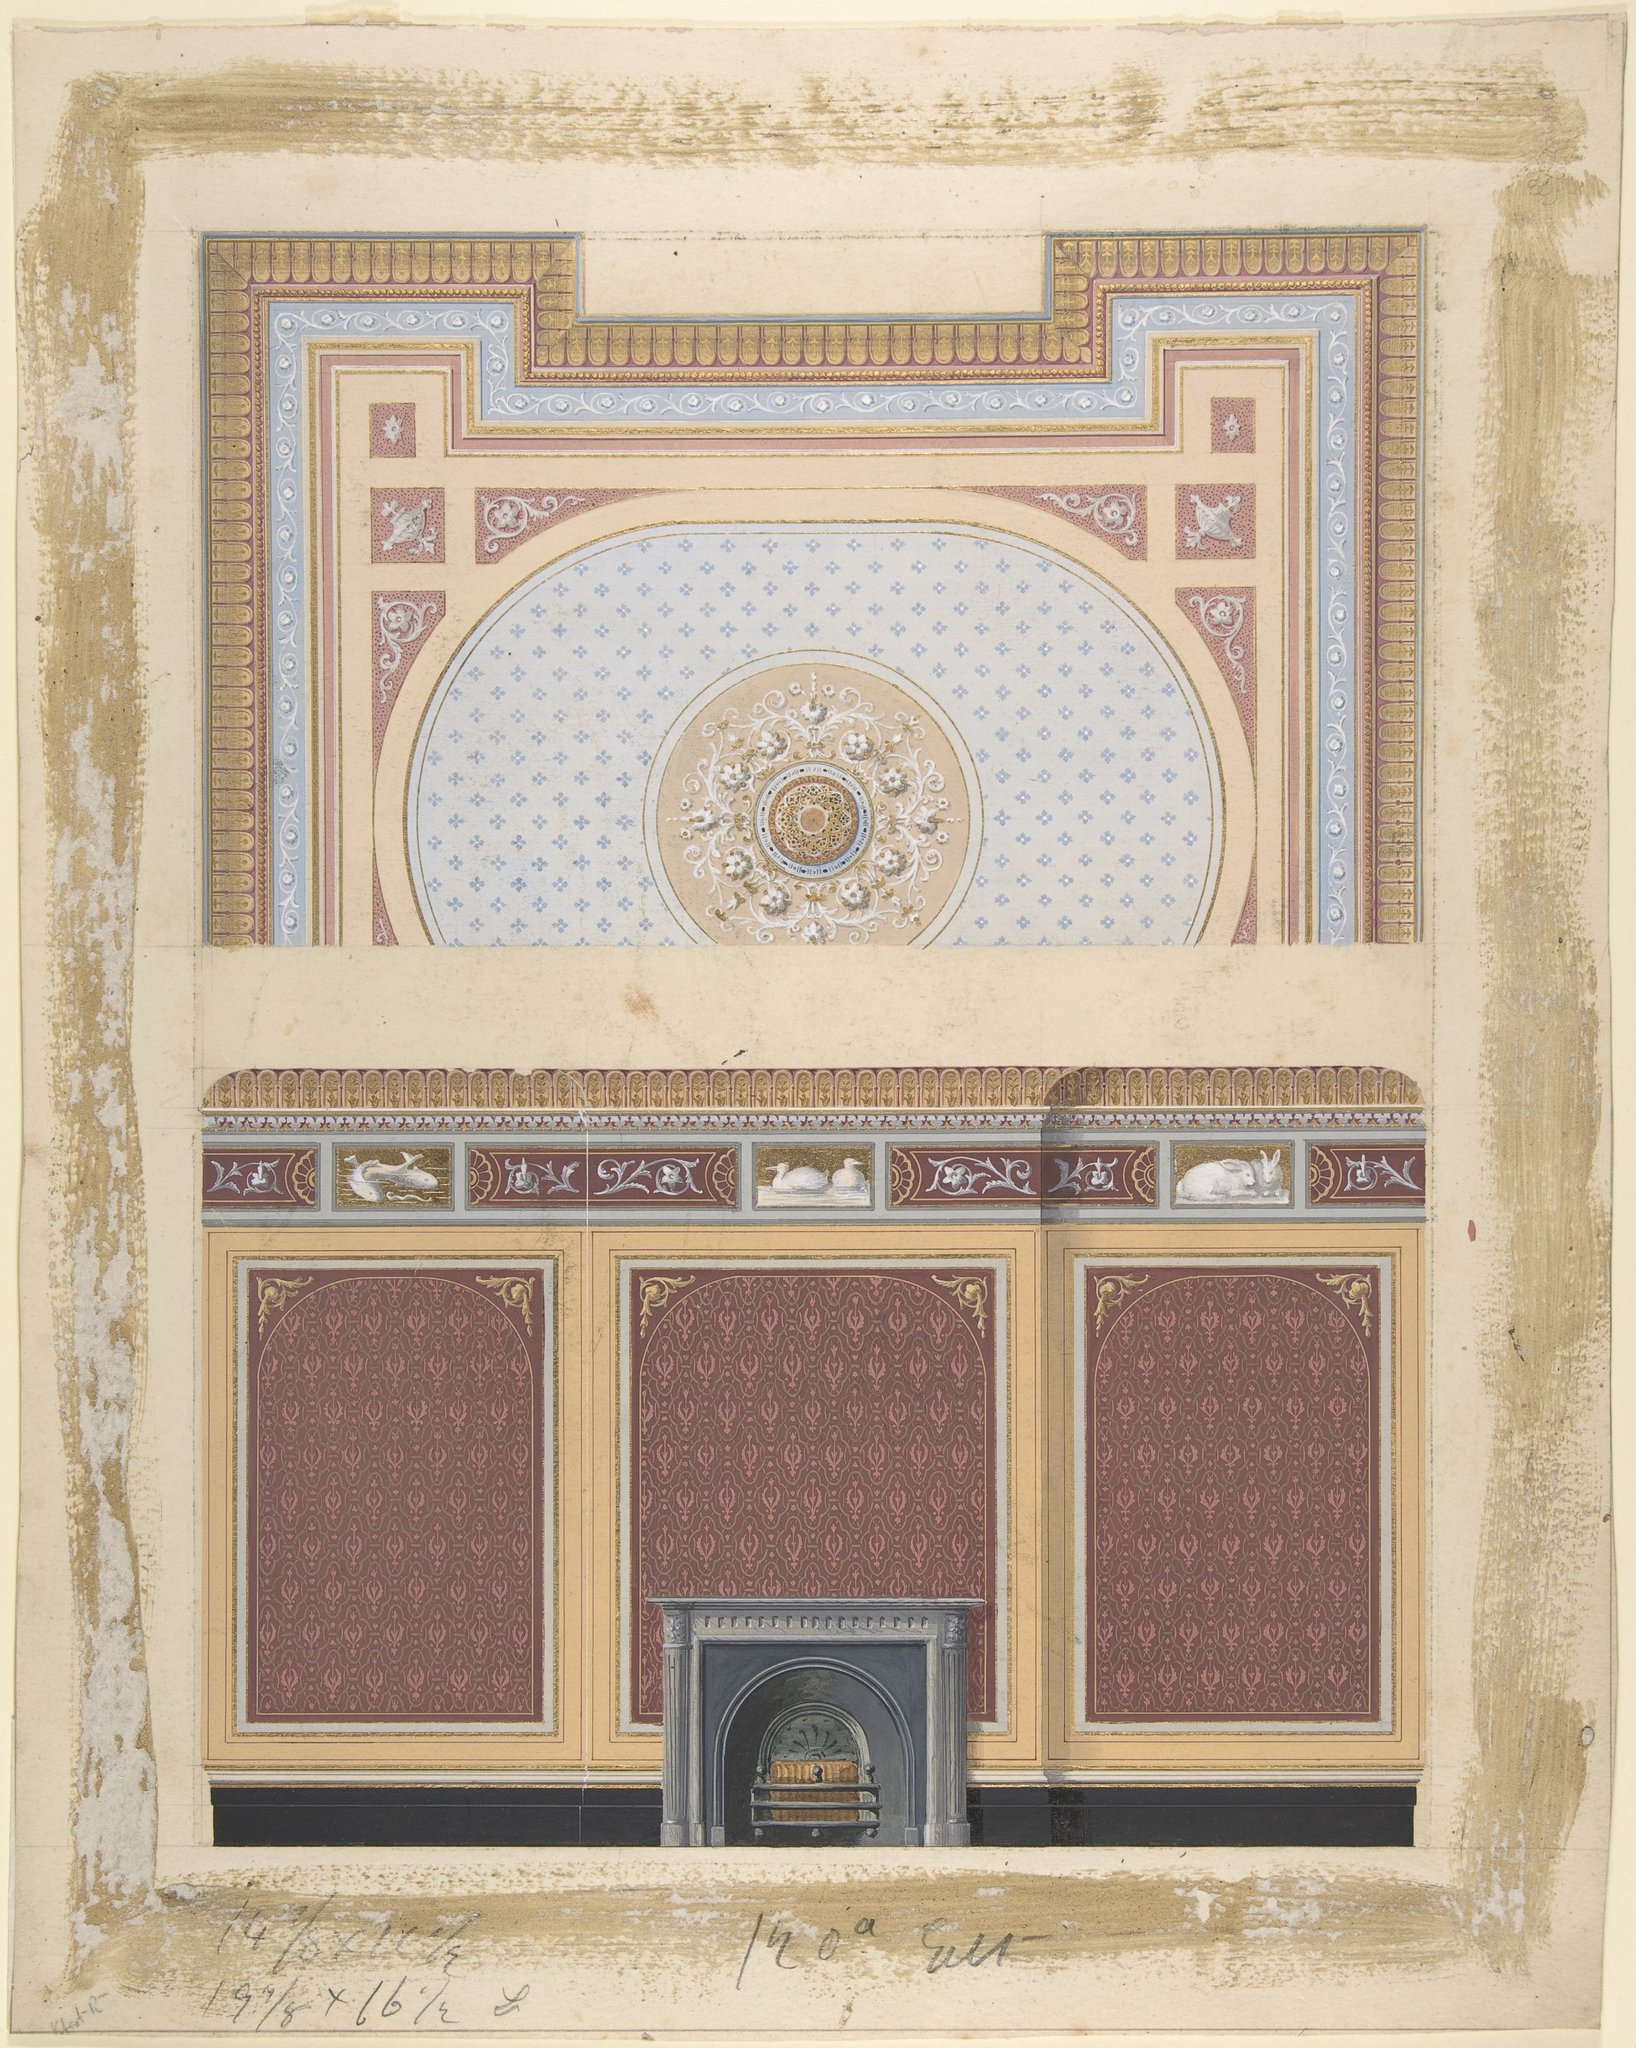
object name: drawing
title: Design for Fireplace Wall and Ceiling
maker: anonymous, british, 19th century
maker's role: artist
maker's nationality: british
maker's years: 1800-1900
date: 1851-1900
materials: gold, gouache, watercolor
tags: architecture,fireplaces,ceilings